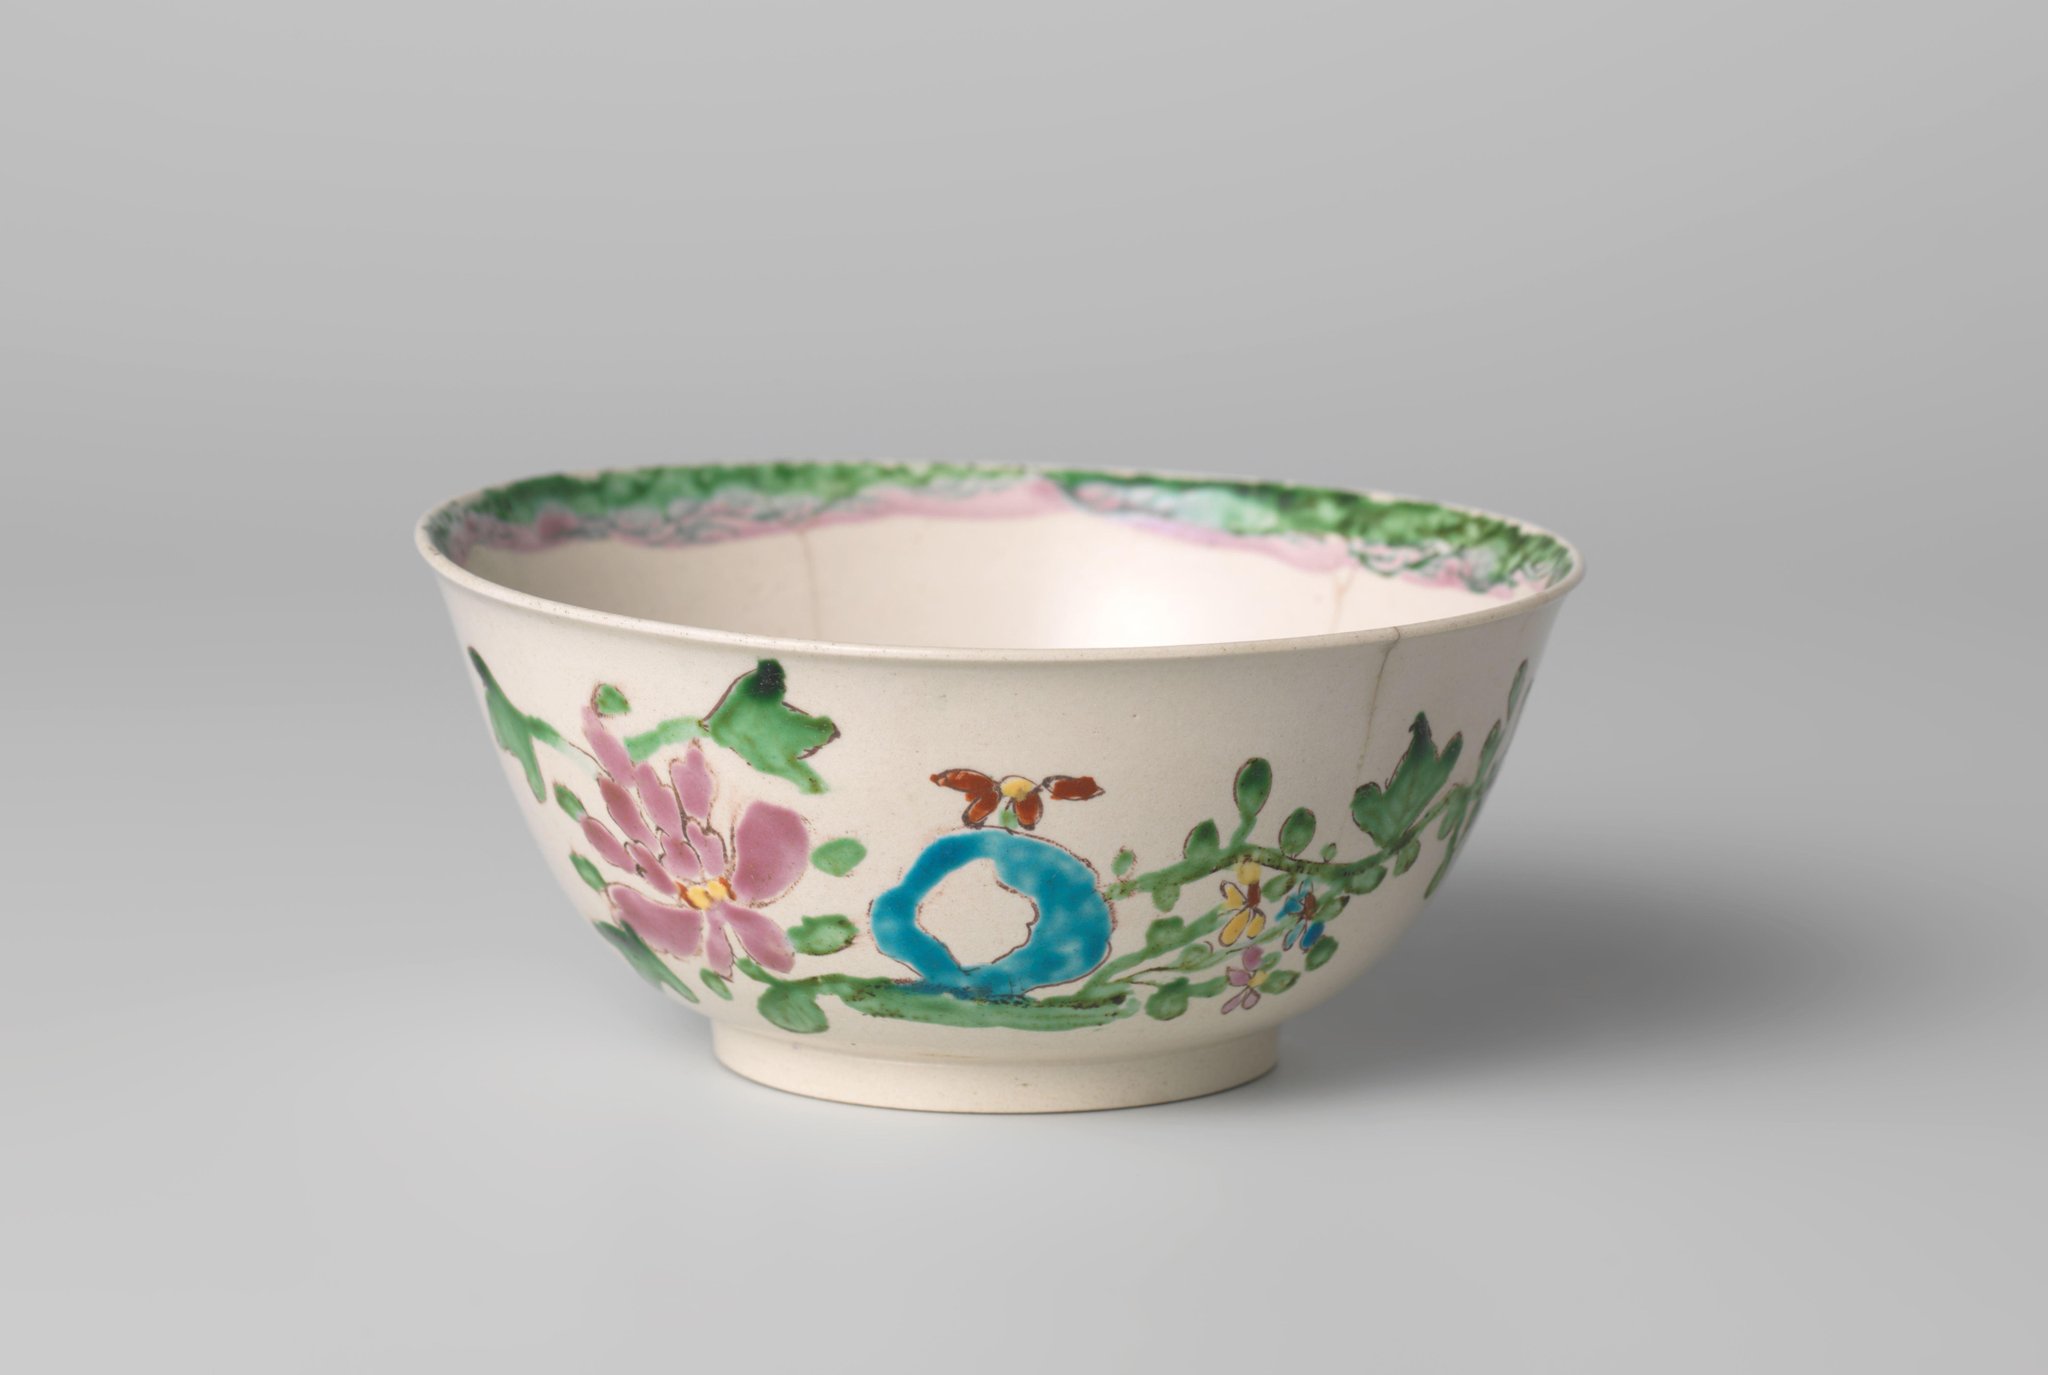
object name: bowl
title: Kom van steengoed, met een polychrome decoratie op de glazuur; Crouch ware.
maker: Anonymous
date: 1740-1760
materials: stoneware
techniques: salt glaze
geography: england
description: Kom van steengoed, met een polychrome decoratie op de glazuur; Crouch ware. De buitenzijde heeft een groene rank met bloemen in blauw, paars, rood en geel. De binnenzijde heeft een groen, paarse rand en op het plat een bloem in paars, geel en groen.